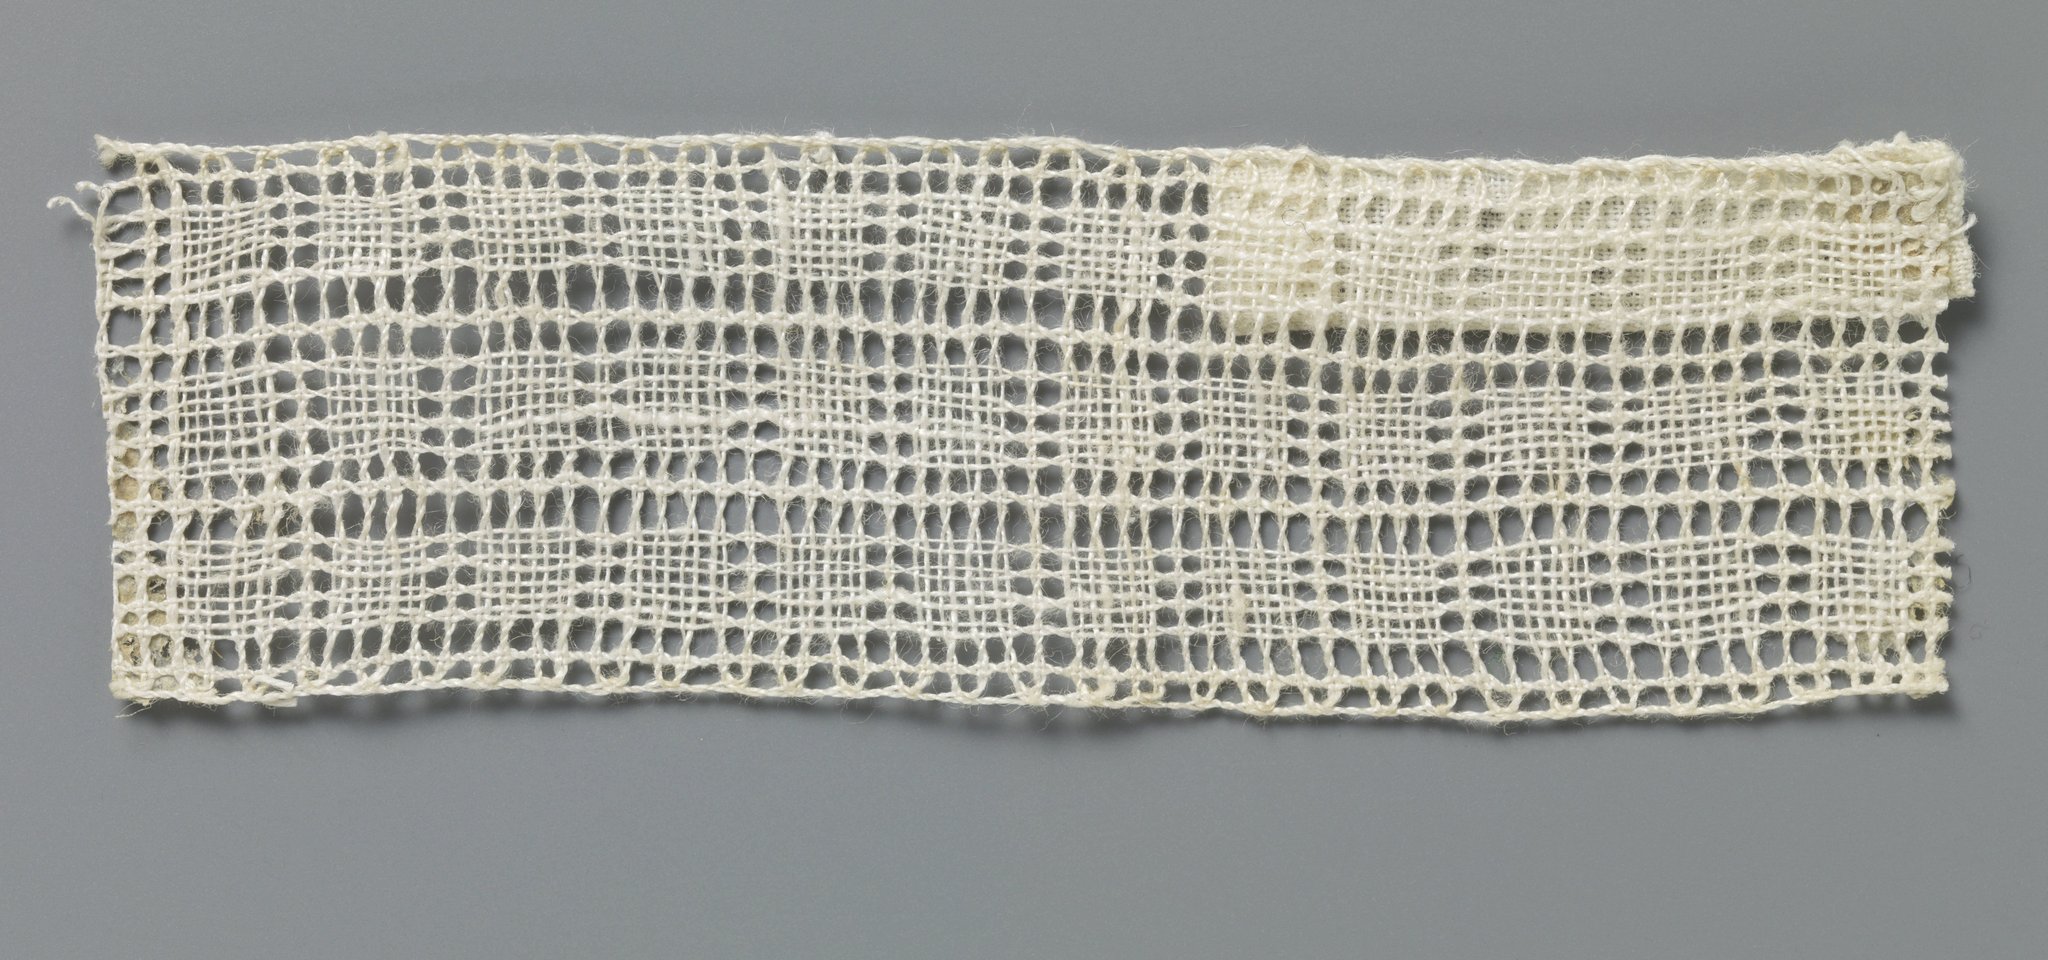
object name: strip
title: Tussenzetsel van kloskant met drie rijen vierkantjes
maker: Anonymous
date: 1900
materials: linen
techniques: lace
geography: russia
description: Tussenzetsel van naturelkleurig kloskant: stropkant. Het zich herhalende en geometrische patroon bestaat uit drie rijen vierkantjes in linnenslag met opengewerkte randjes. Boven- en onderzijde van de strook zijn recht afgewerkt.